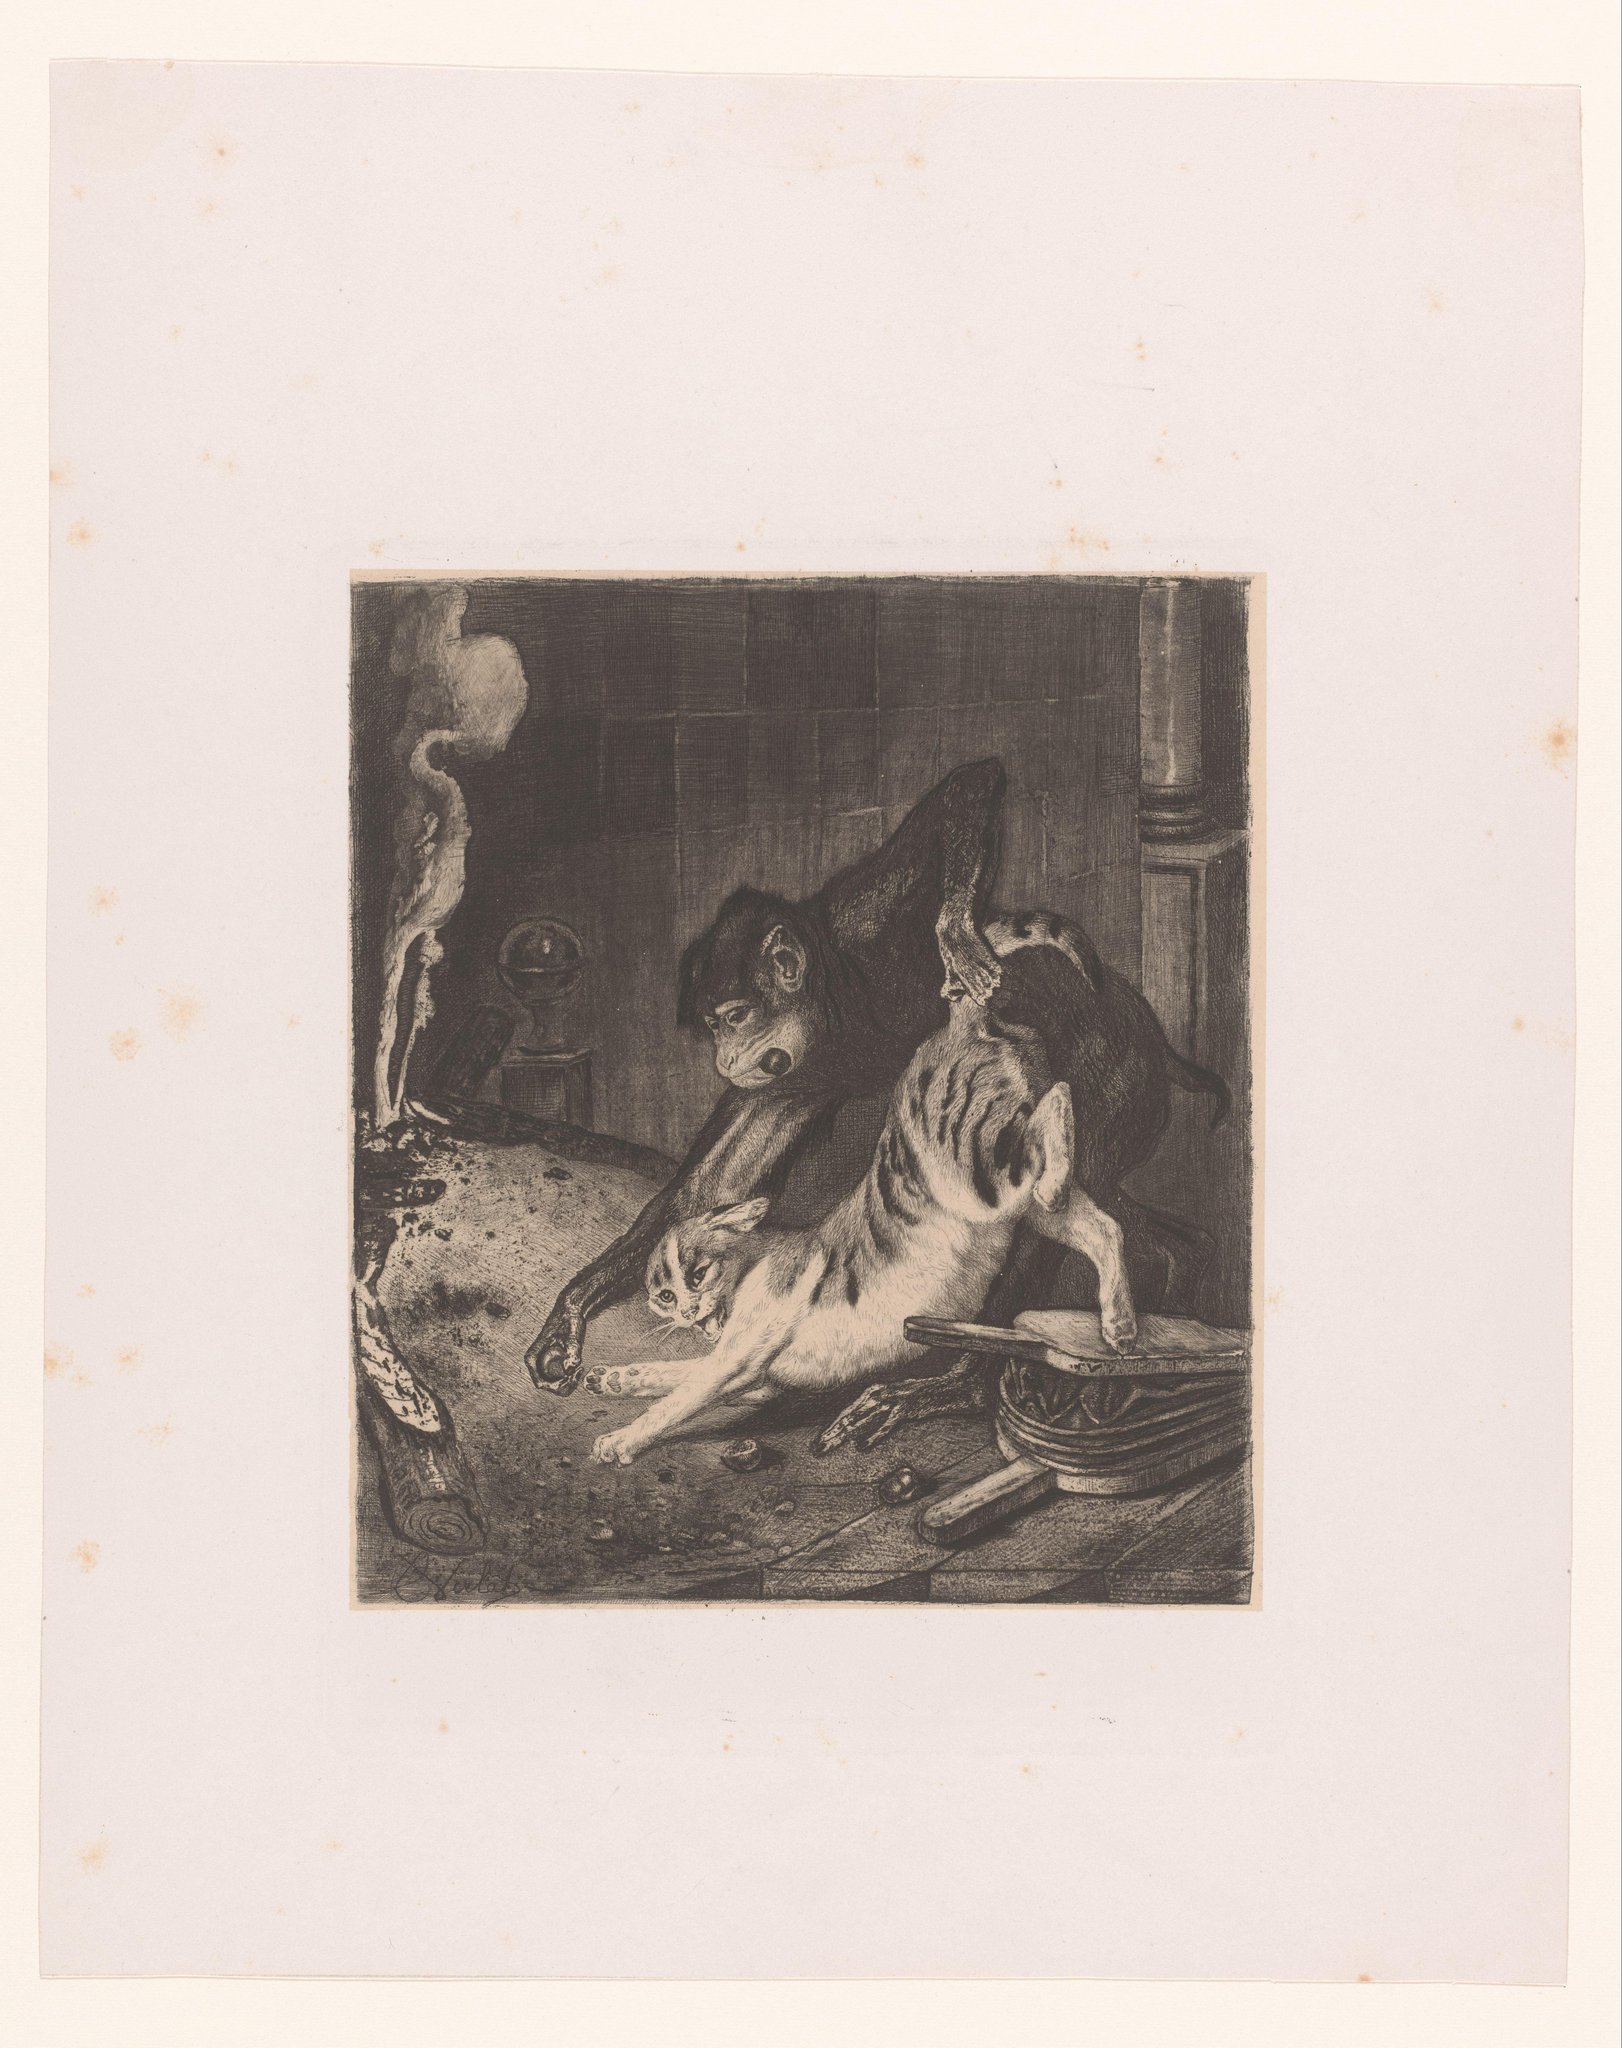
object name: print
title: Aap dwingt een kat de kastanjes uit het vuur te halen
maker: charles verlat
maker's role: painter, print maker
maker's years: 1824-1890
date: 1834-1890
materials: paper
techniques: drypoint, etching, intaglio, retroussage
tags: cat, monkeys, apes, fables, fruits: chestnut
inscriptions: collector's mark: Lugt 2228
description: De aap Bertrand haalt de kat Raton over kastanjes voor hem uit het vuur te halen. Hij belooft hem een deel, maar de aap eet alles zelf op. Fabel van Jean de La Fontaine "De aap en de kat".